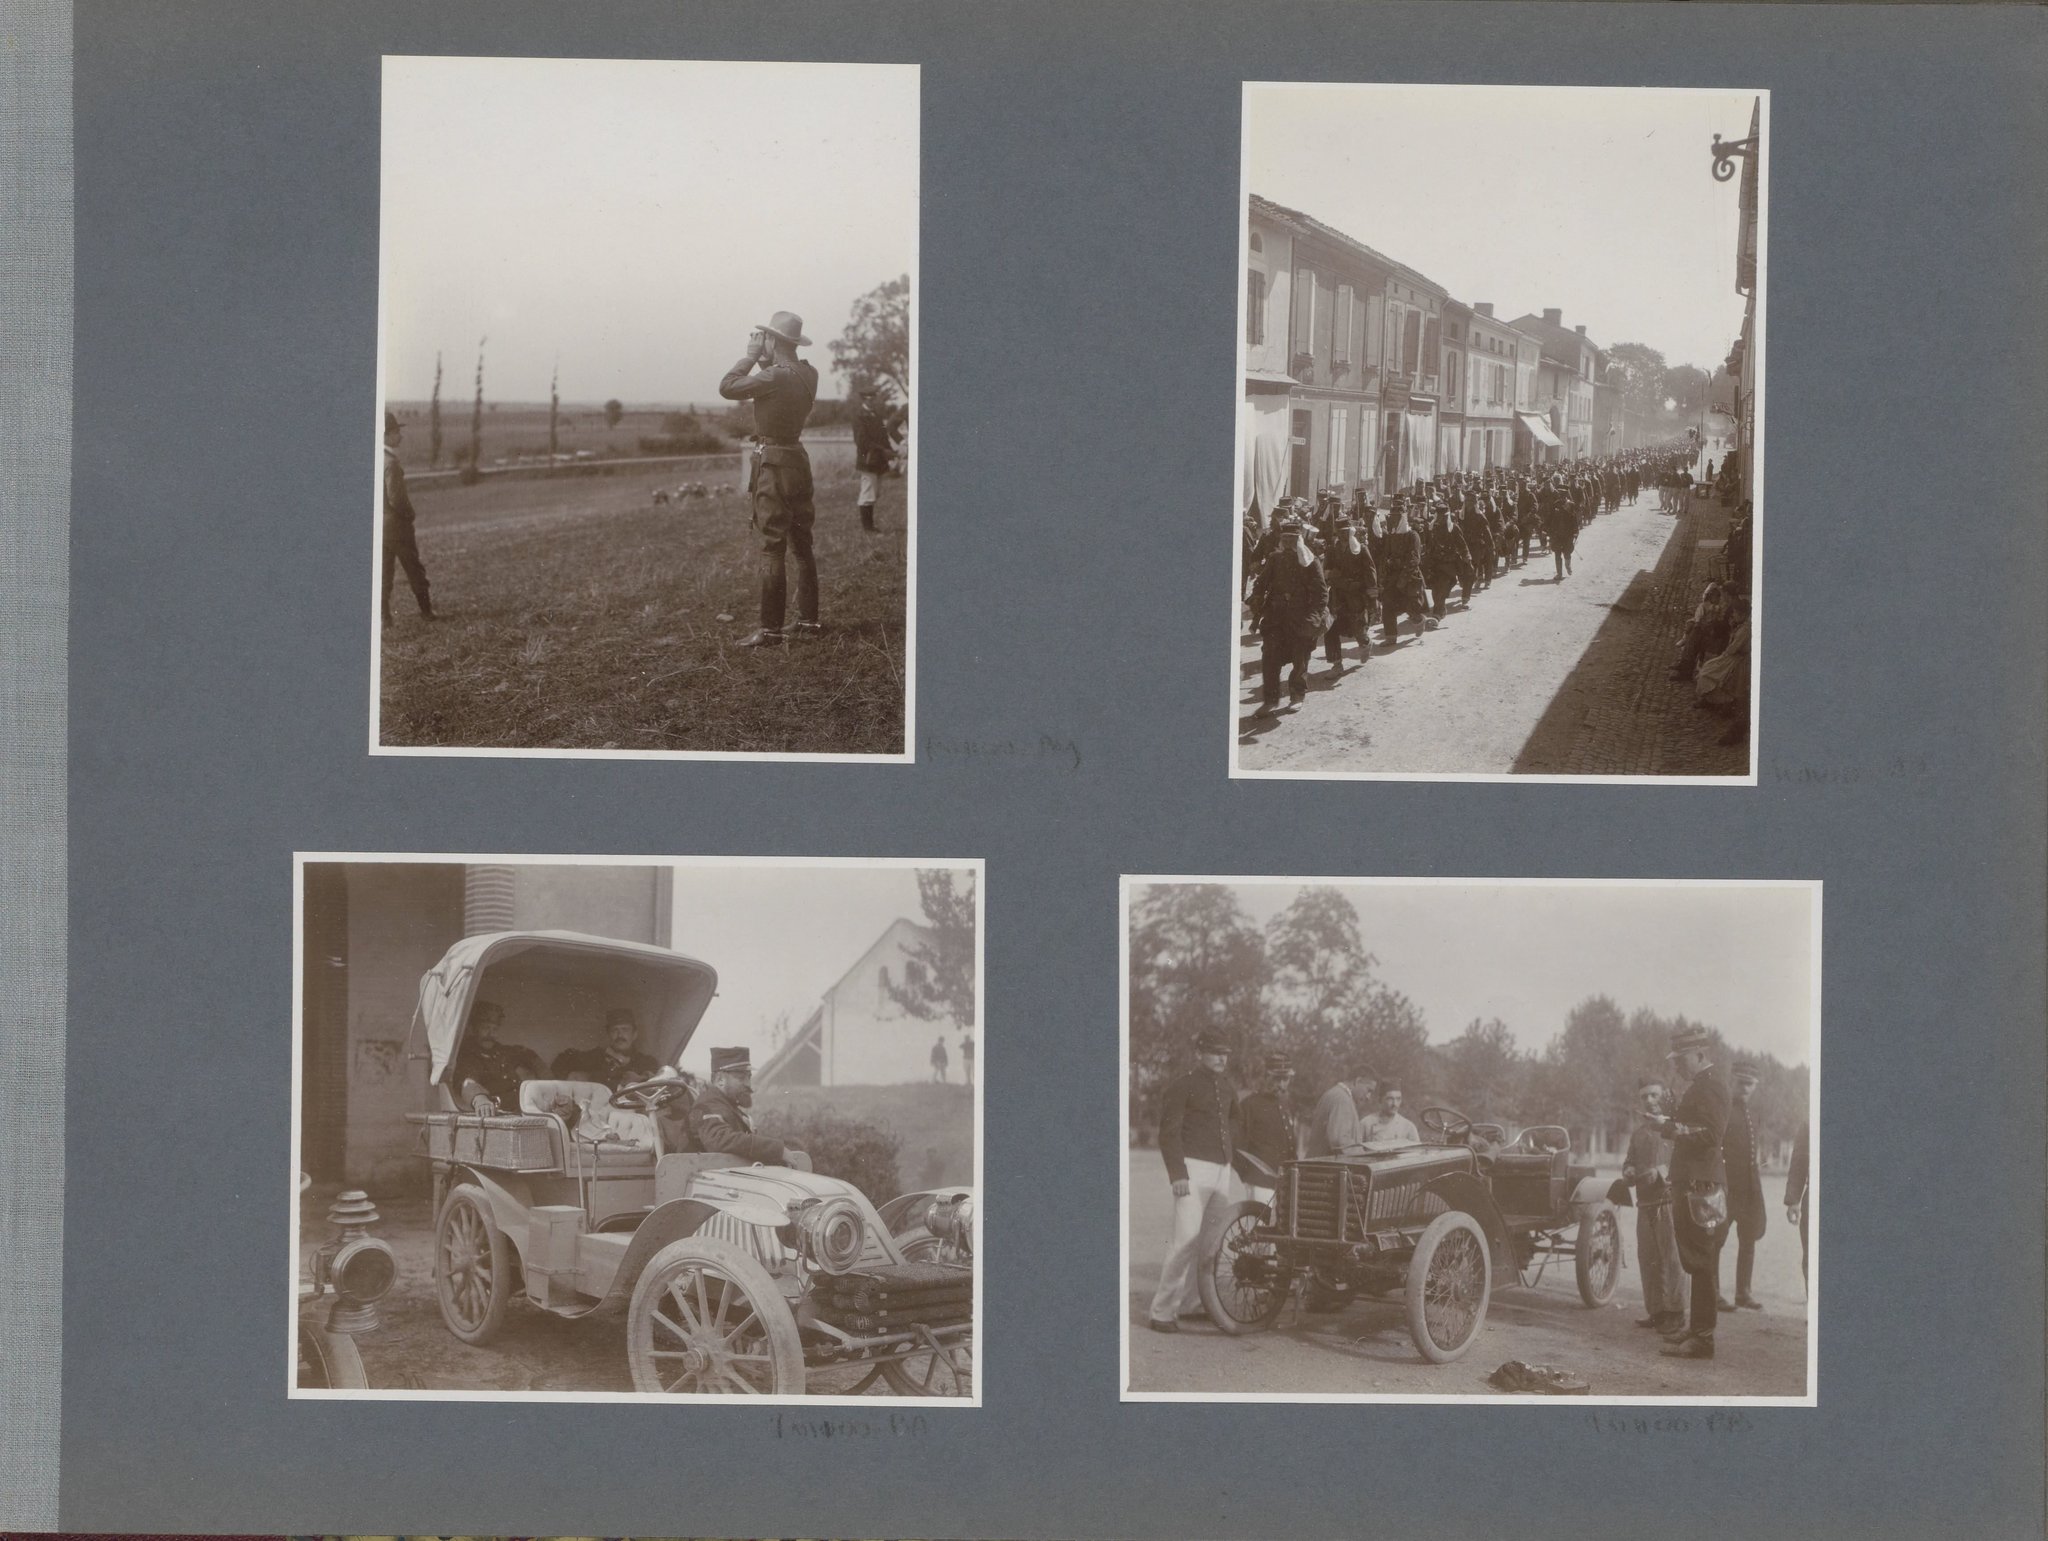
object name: album leaf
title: Militairen in een auto in Frankrijk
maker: Anonymous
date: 1902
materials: paper, photographic support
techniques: daylight paper print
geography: france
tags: land forces, automobile, france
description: Onderdeel van Fotoalbum van een legeroefening in Zuidwest-Frankrijk in 1902.